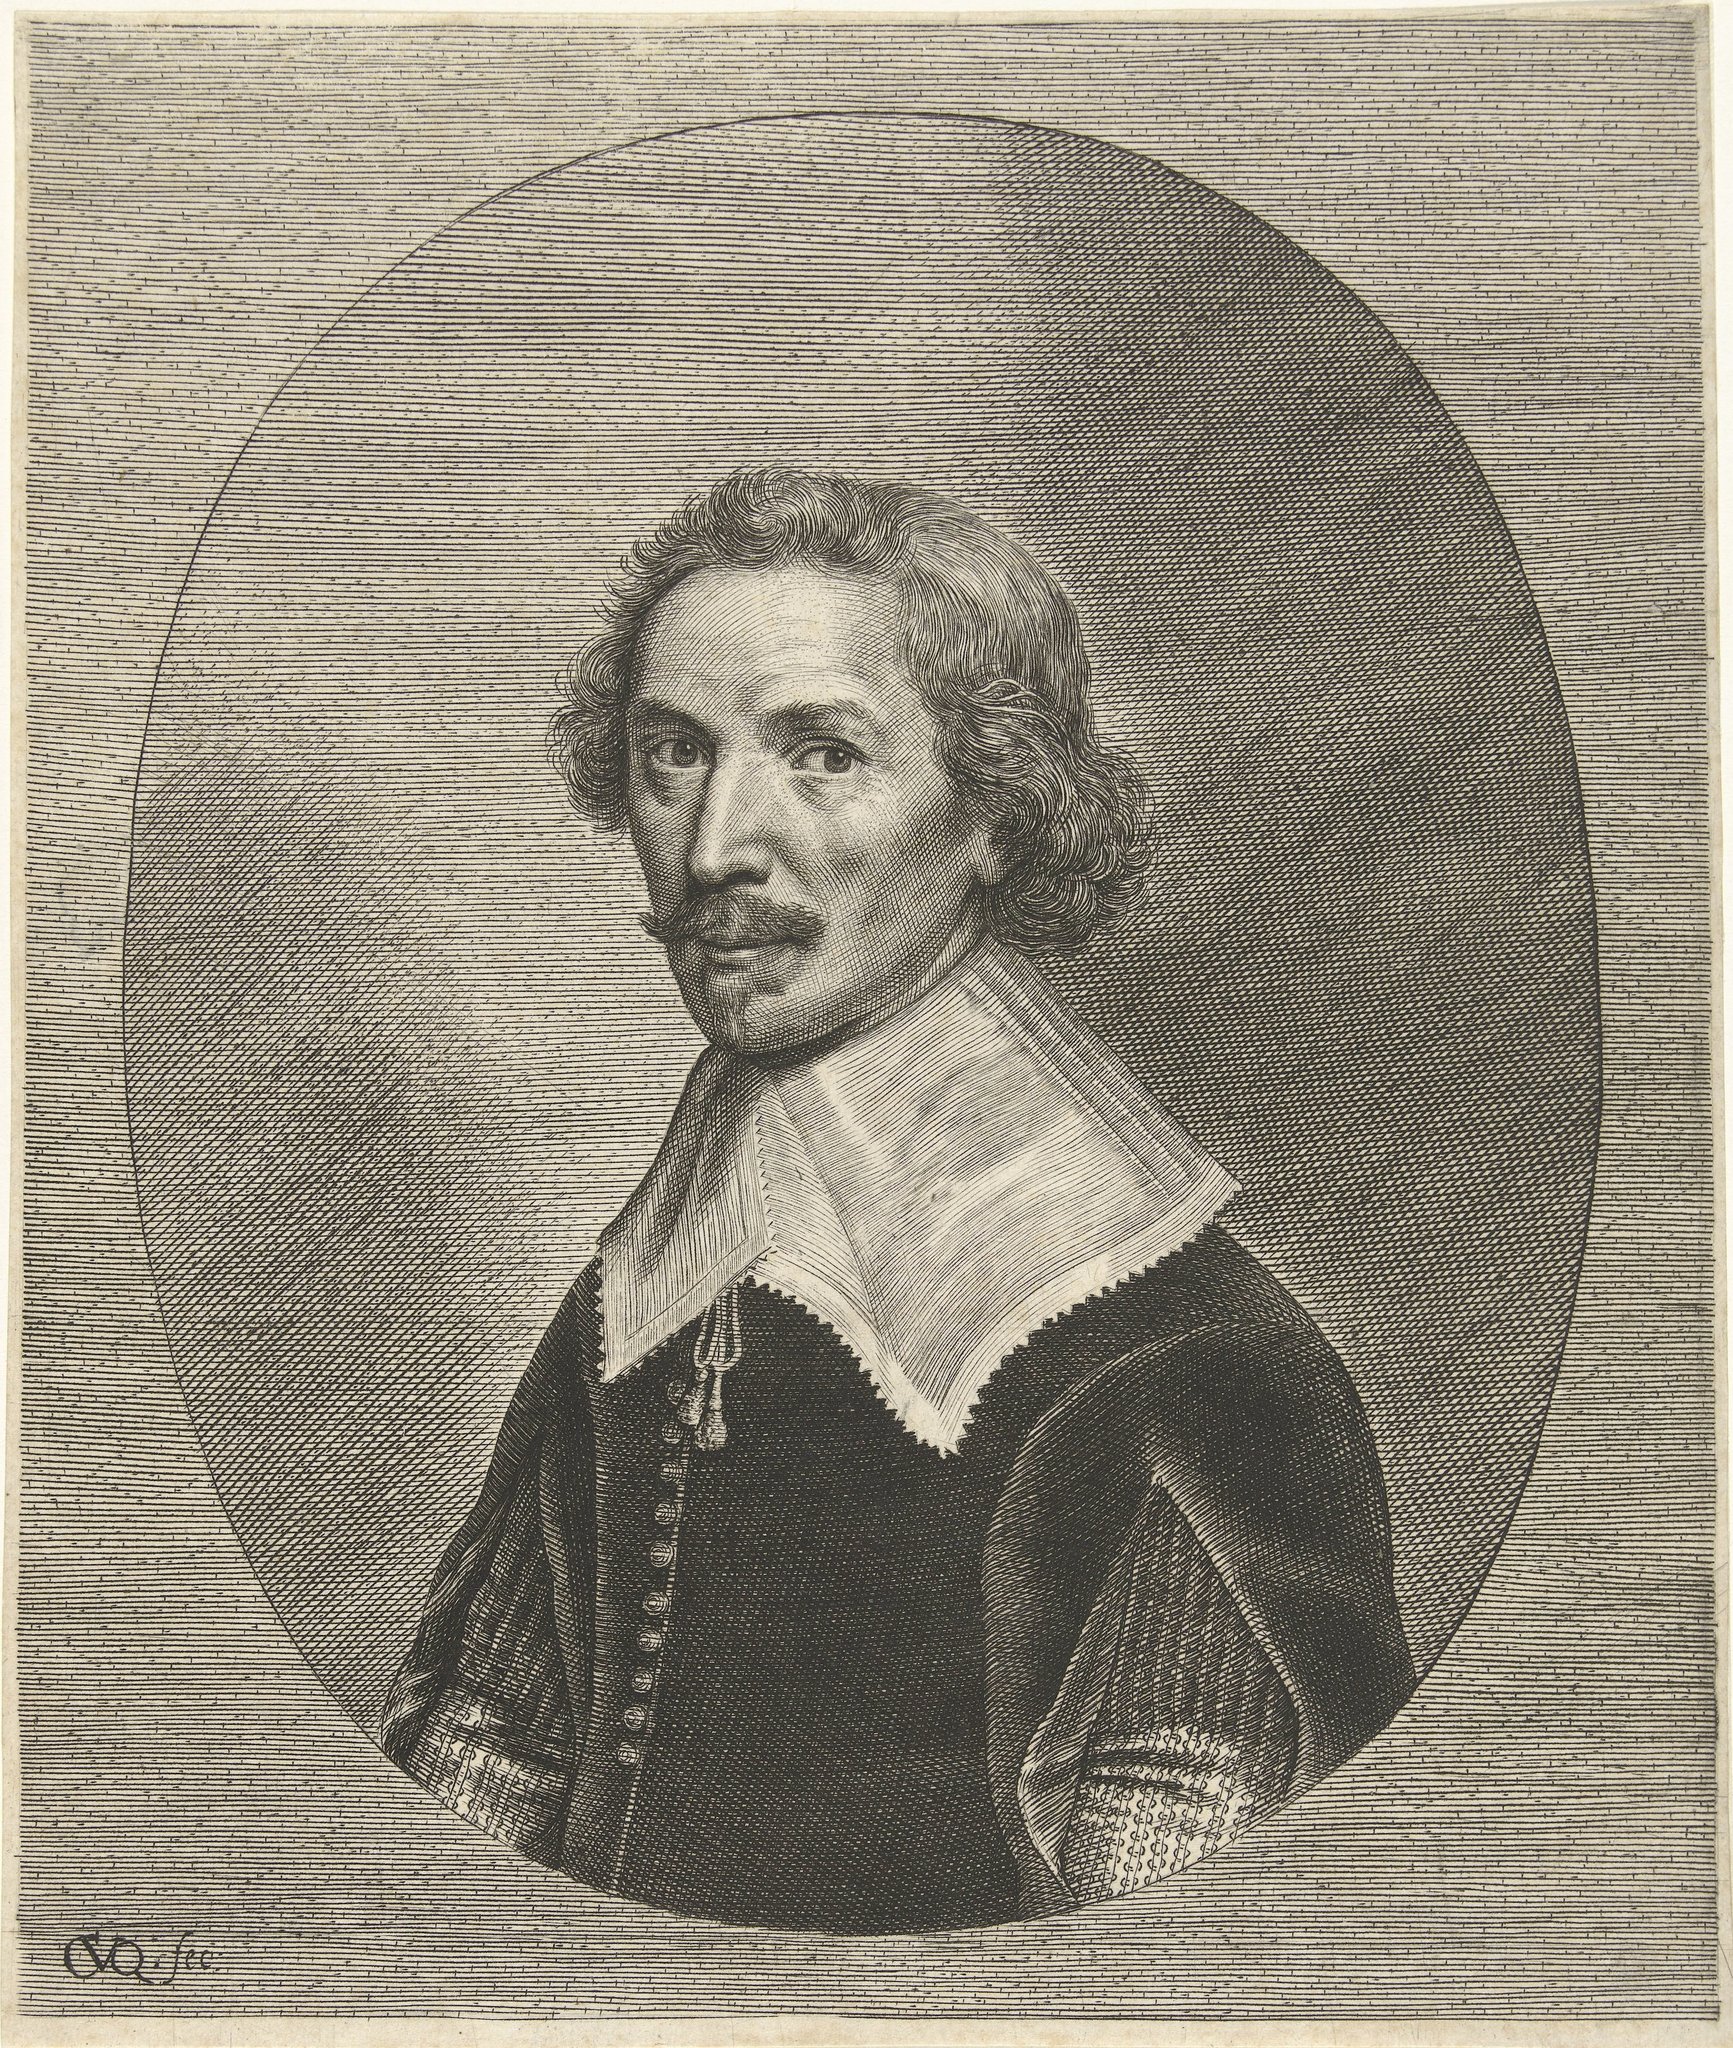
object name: print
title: Portret van onbekende man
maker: crispijn van den queborn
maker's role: print maker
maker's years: 1595-1652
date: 1614-1652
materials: paper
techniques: engraving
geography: the hague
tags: adult man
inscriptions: collector's mark: Lugt 2228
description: Portret van onbekende man in een ovaal naar links.